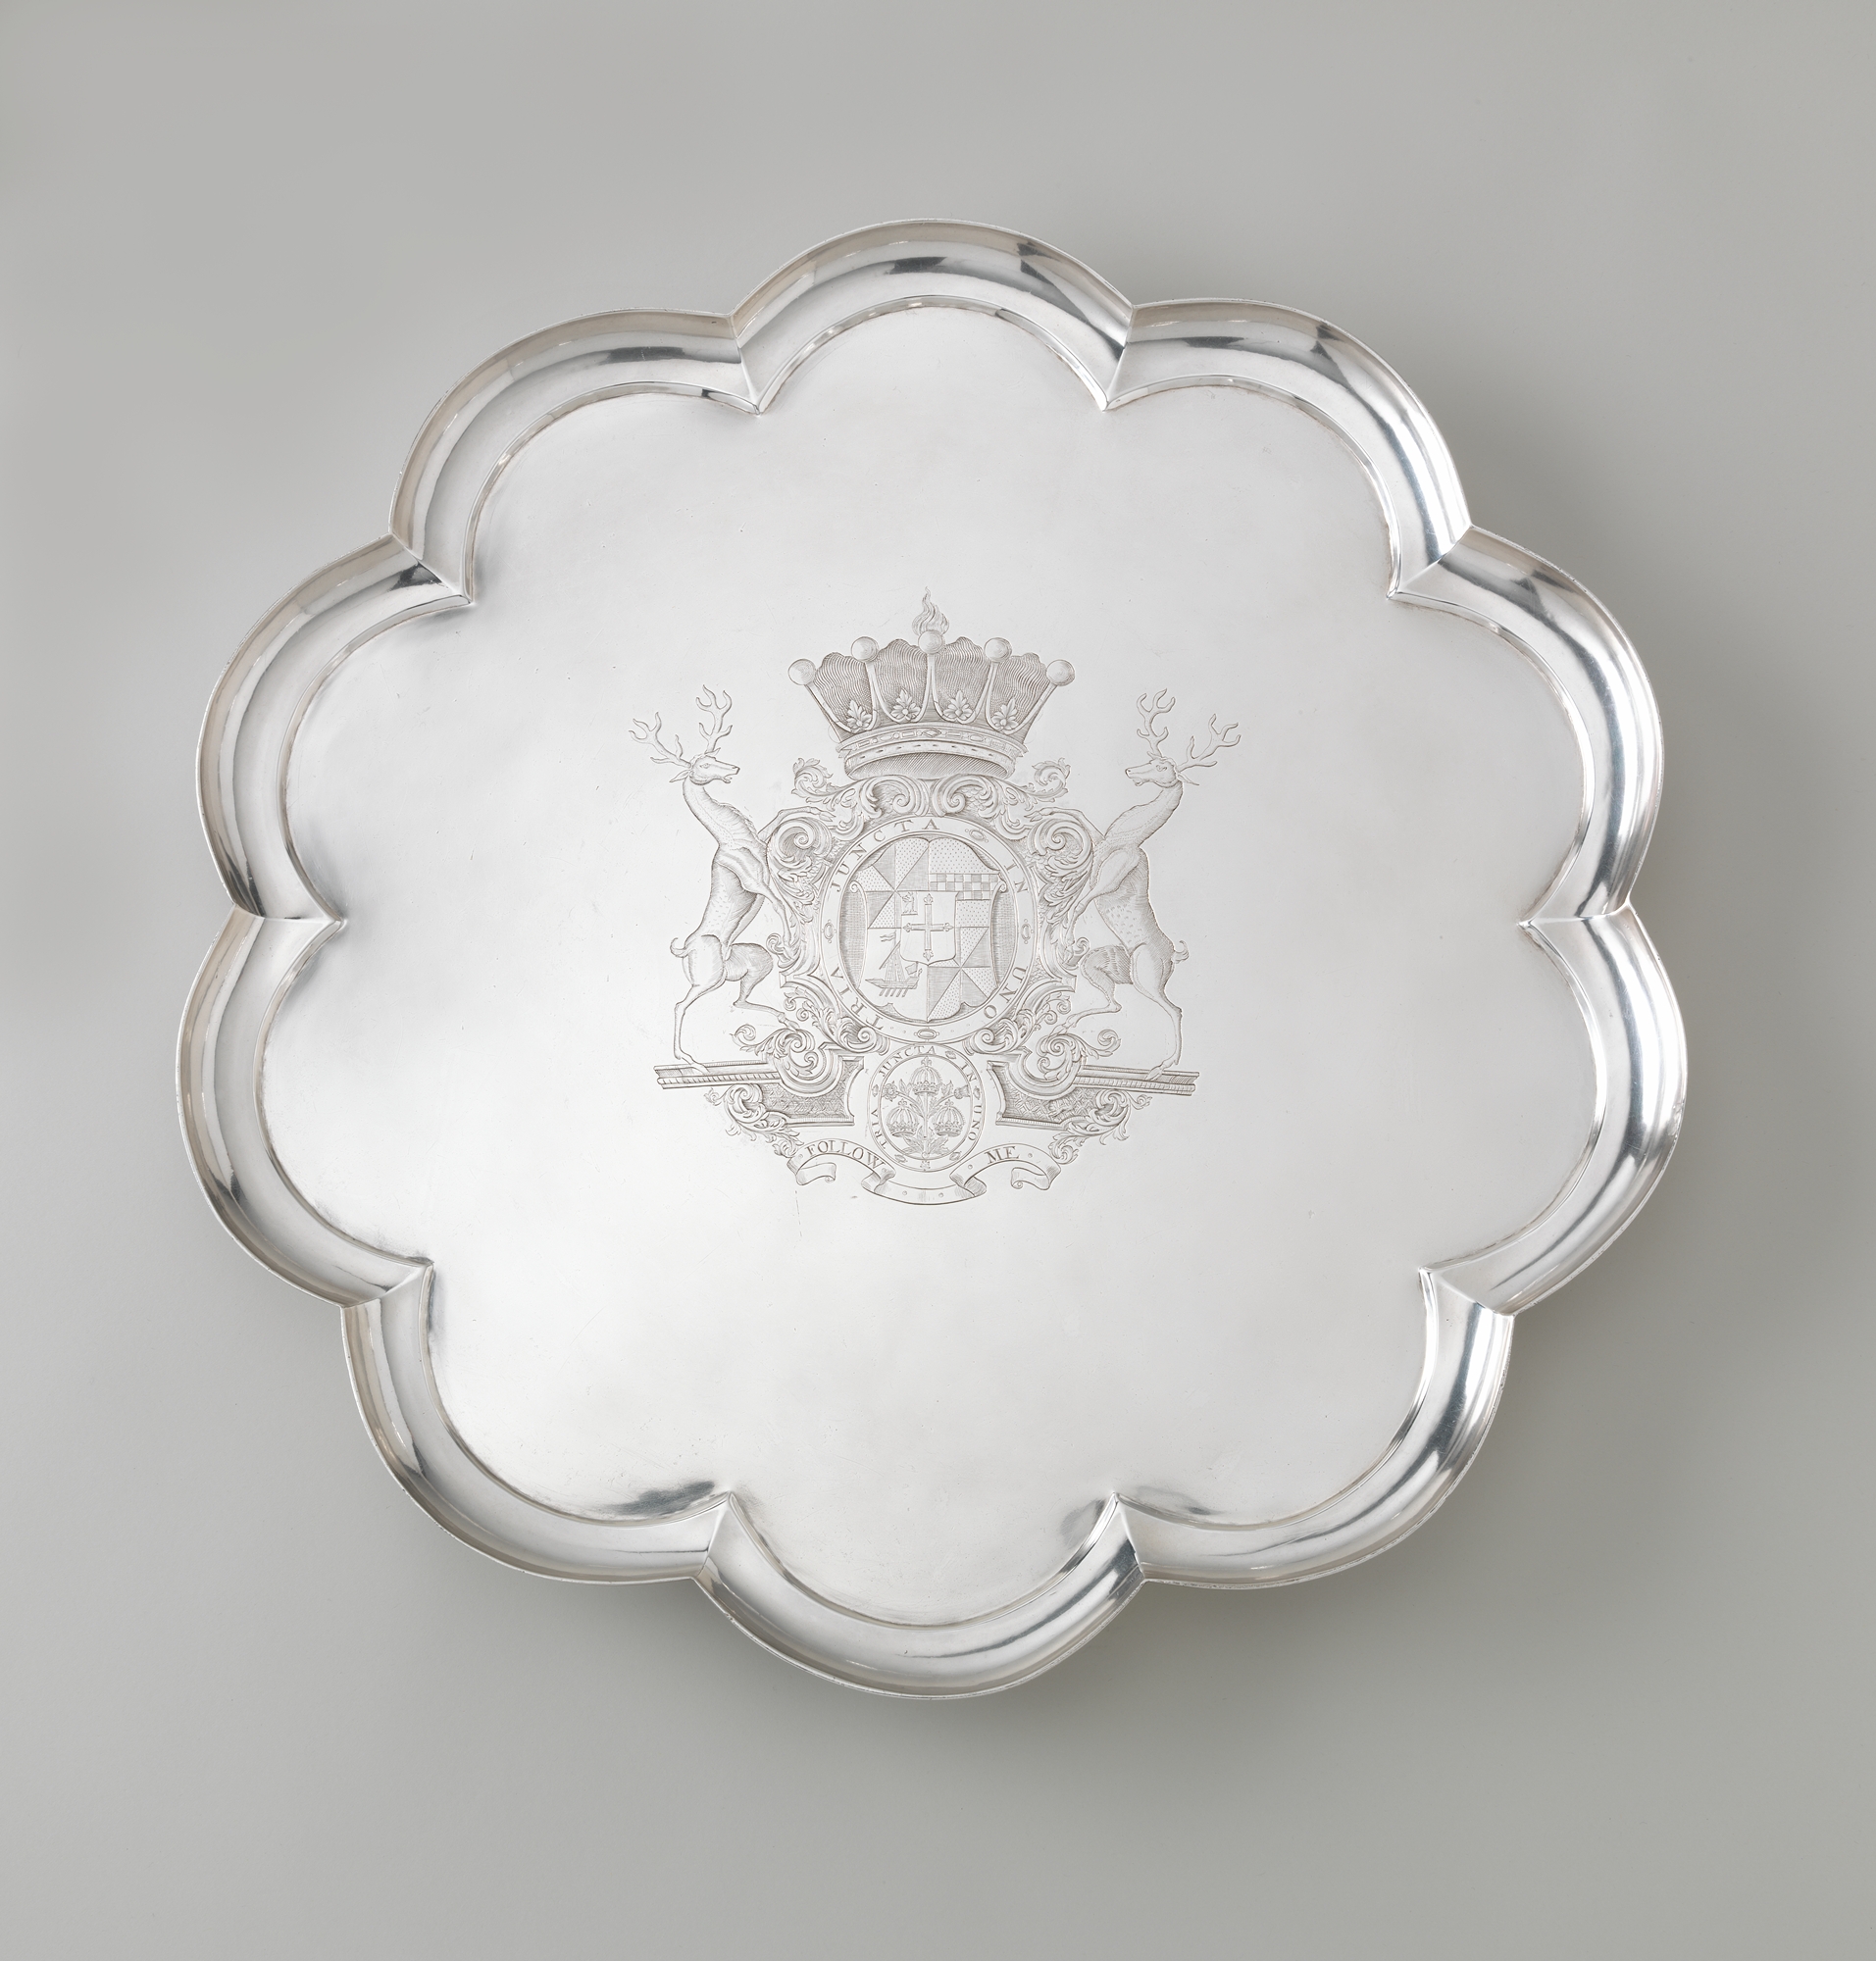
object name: salver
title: Decafoil salver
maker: david willaume i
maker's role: maker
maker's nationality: british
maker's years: 1658-1741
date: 1722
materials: silver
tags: coat of arms